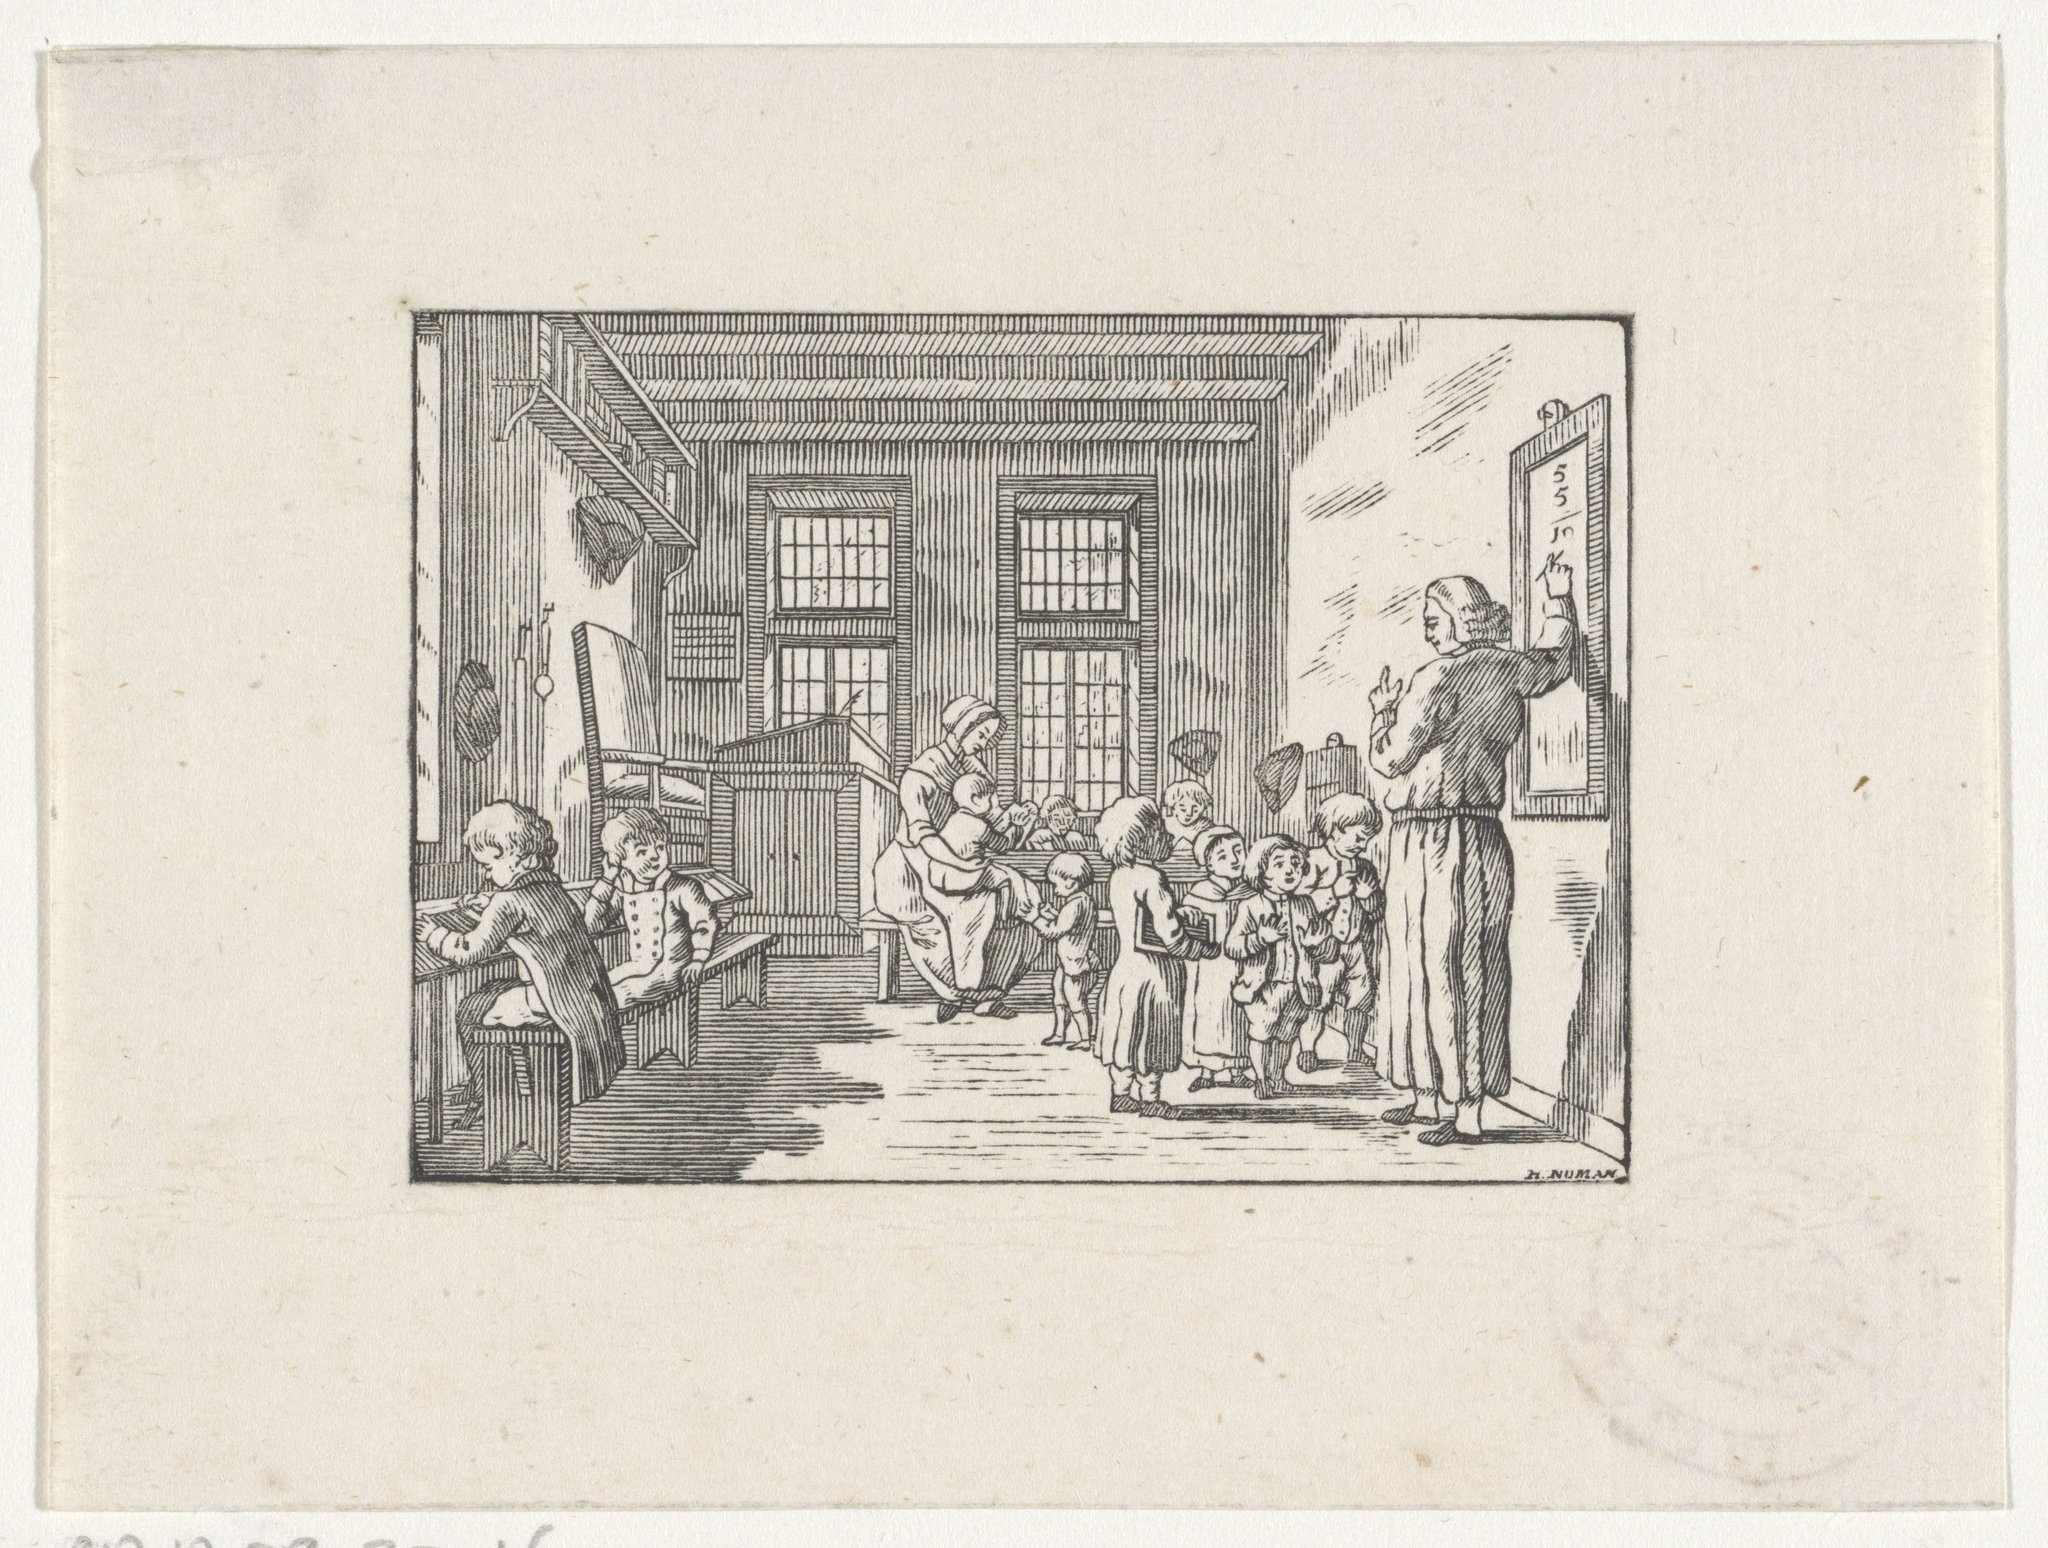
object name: print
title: Vrouw in een klaslokaal leert kinderen rekenen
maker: hendrik numan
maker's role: draughtsman, print maker, publisher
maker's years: 1736-1788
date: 1746-1788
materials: paper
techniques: woodcut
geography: haarlem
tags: boy (child between toddler and youth), girl (child between toddler and youth), scholastic education, tuition, mathematics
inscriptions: collector's mark: Lugt 240